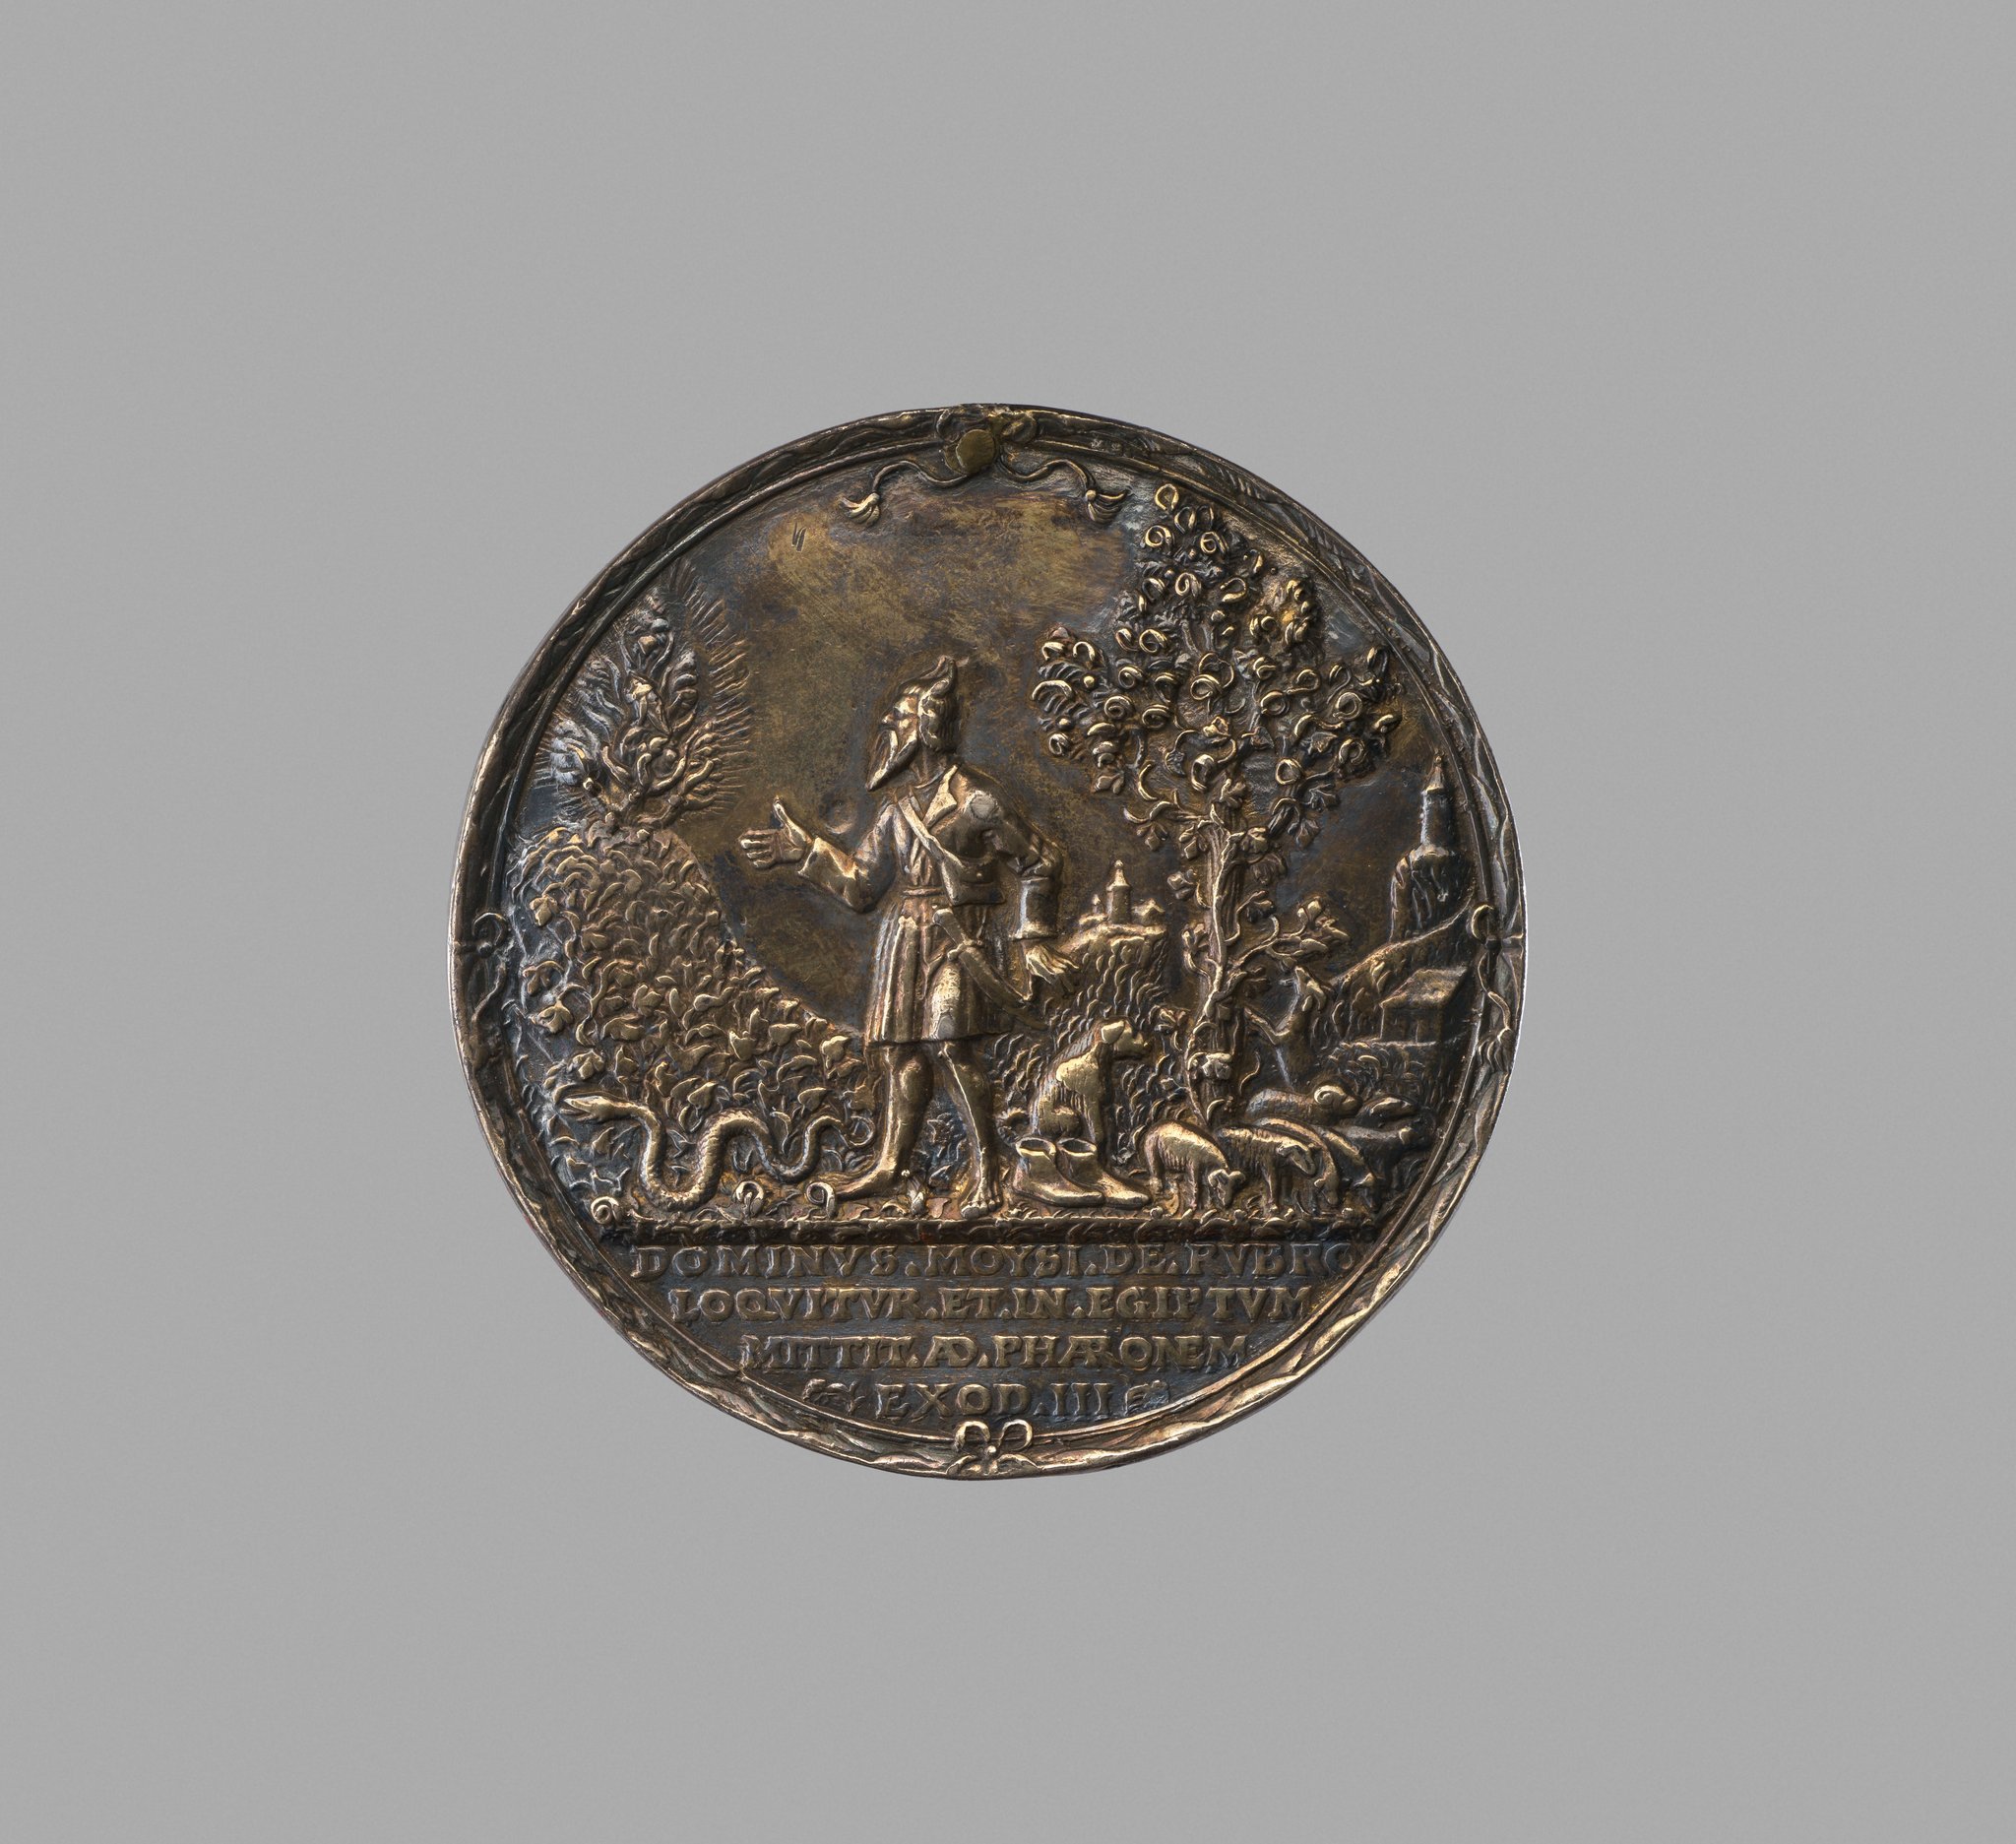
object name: medal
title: Moses and the Burning Bush and the Coming of the Three Kings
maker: hans reinhart the elder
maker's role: artist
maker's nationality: german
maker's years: 1500-1581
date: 1538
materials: silver gilt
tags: cows,dogs,snakes,holy family,moses